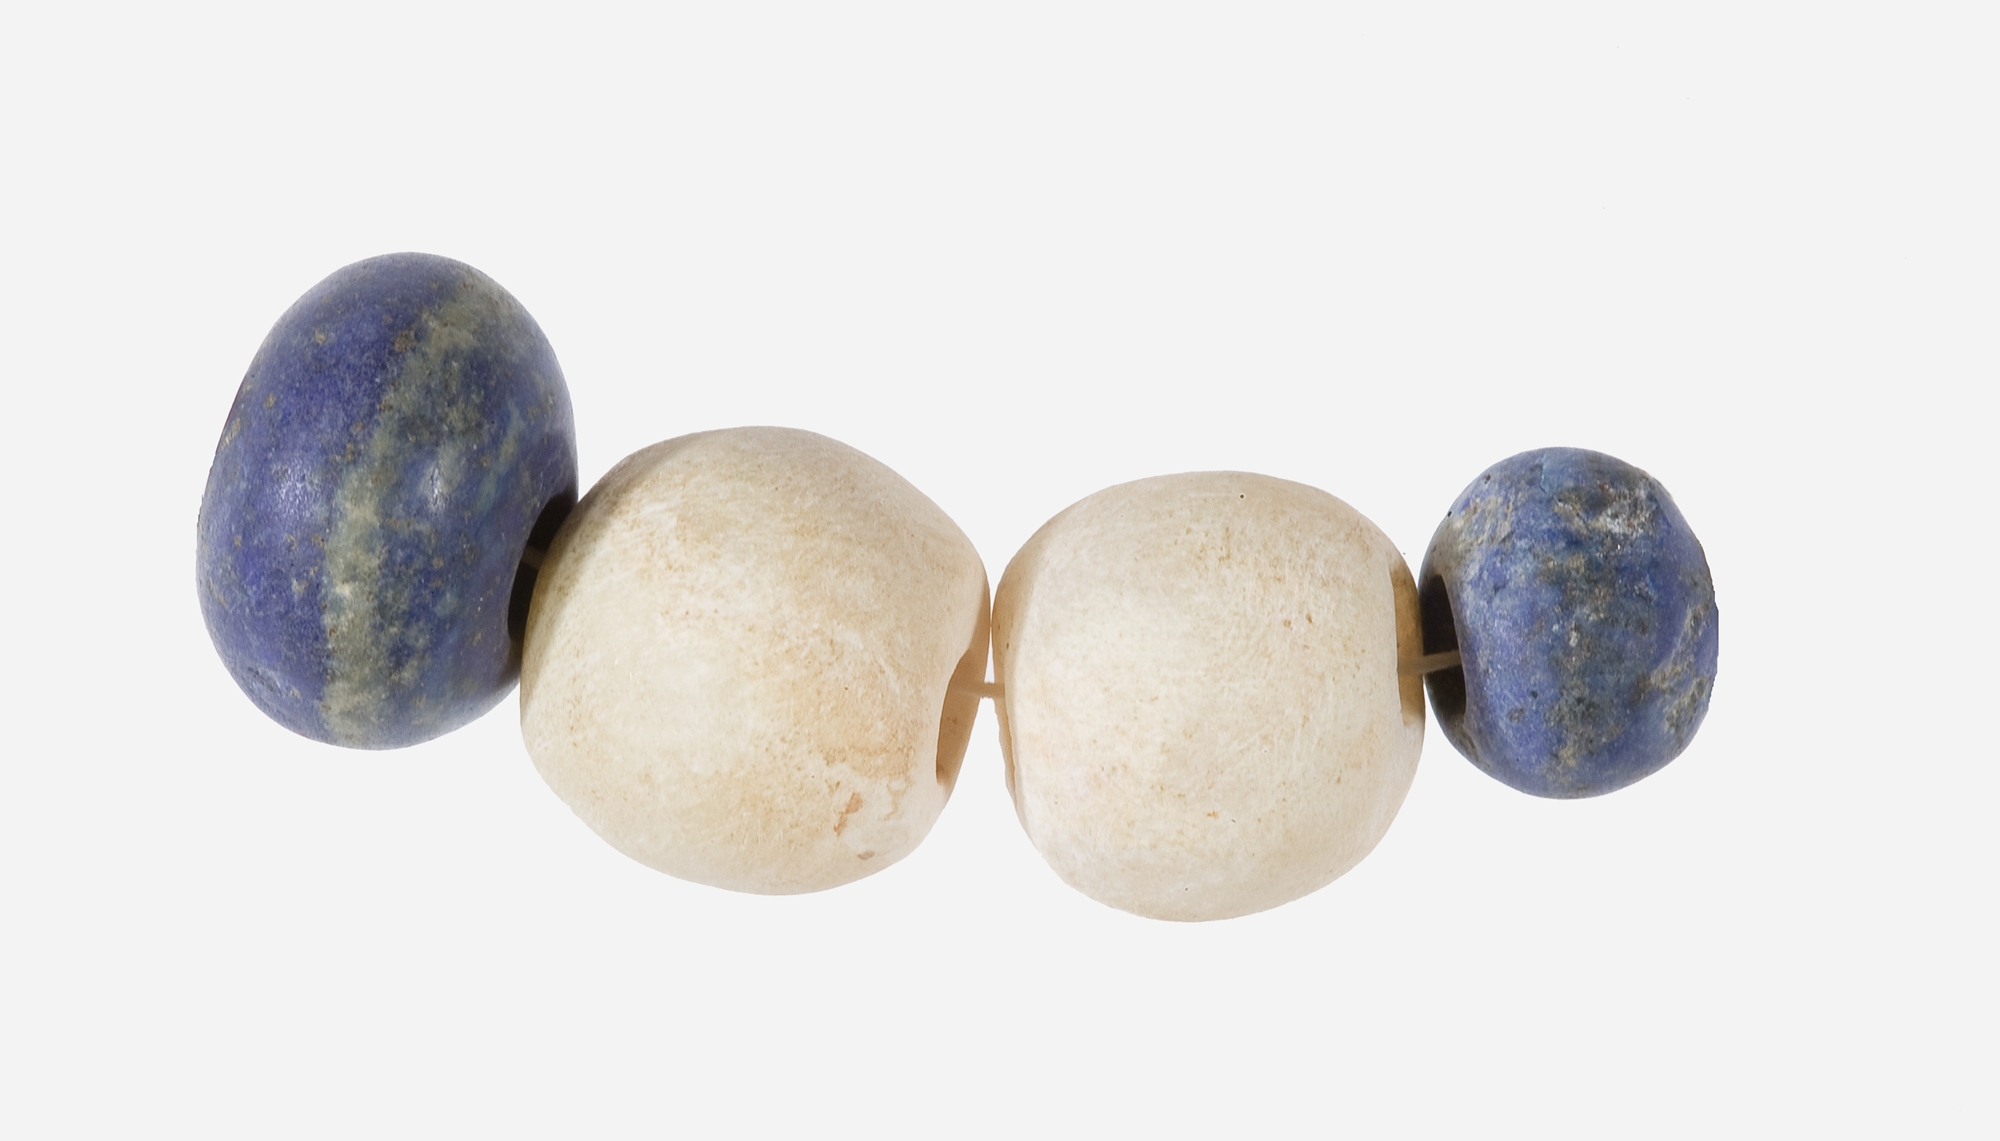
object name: bead, string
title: String of beads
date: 3650-3100 BCE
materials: lapis lazuli, stone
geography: egypt